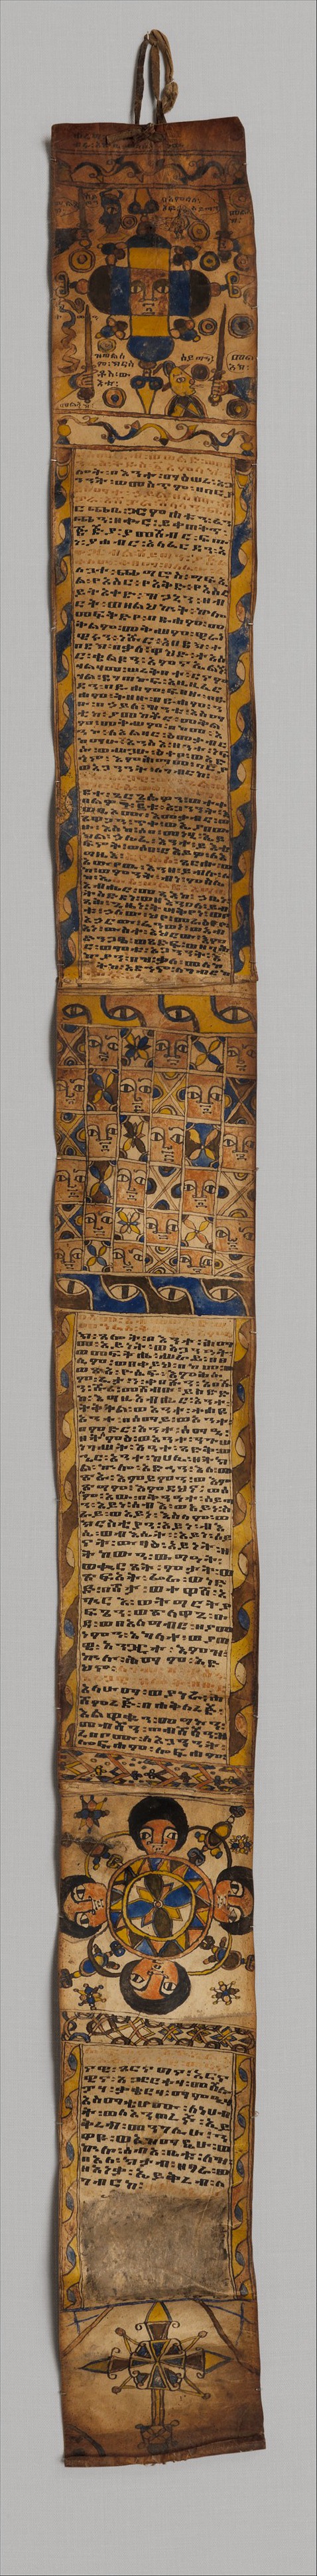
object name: scroll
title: Tälsäm or yä bərana kətab (healing scroll)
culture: tigrinya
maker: northern highlands däbtära (religious scholar)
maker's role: artist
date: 1701-1900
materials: cotton, ink, parchment, pigment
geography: ethiopia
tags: scrolls,faces